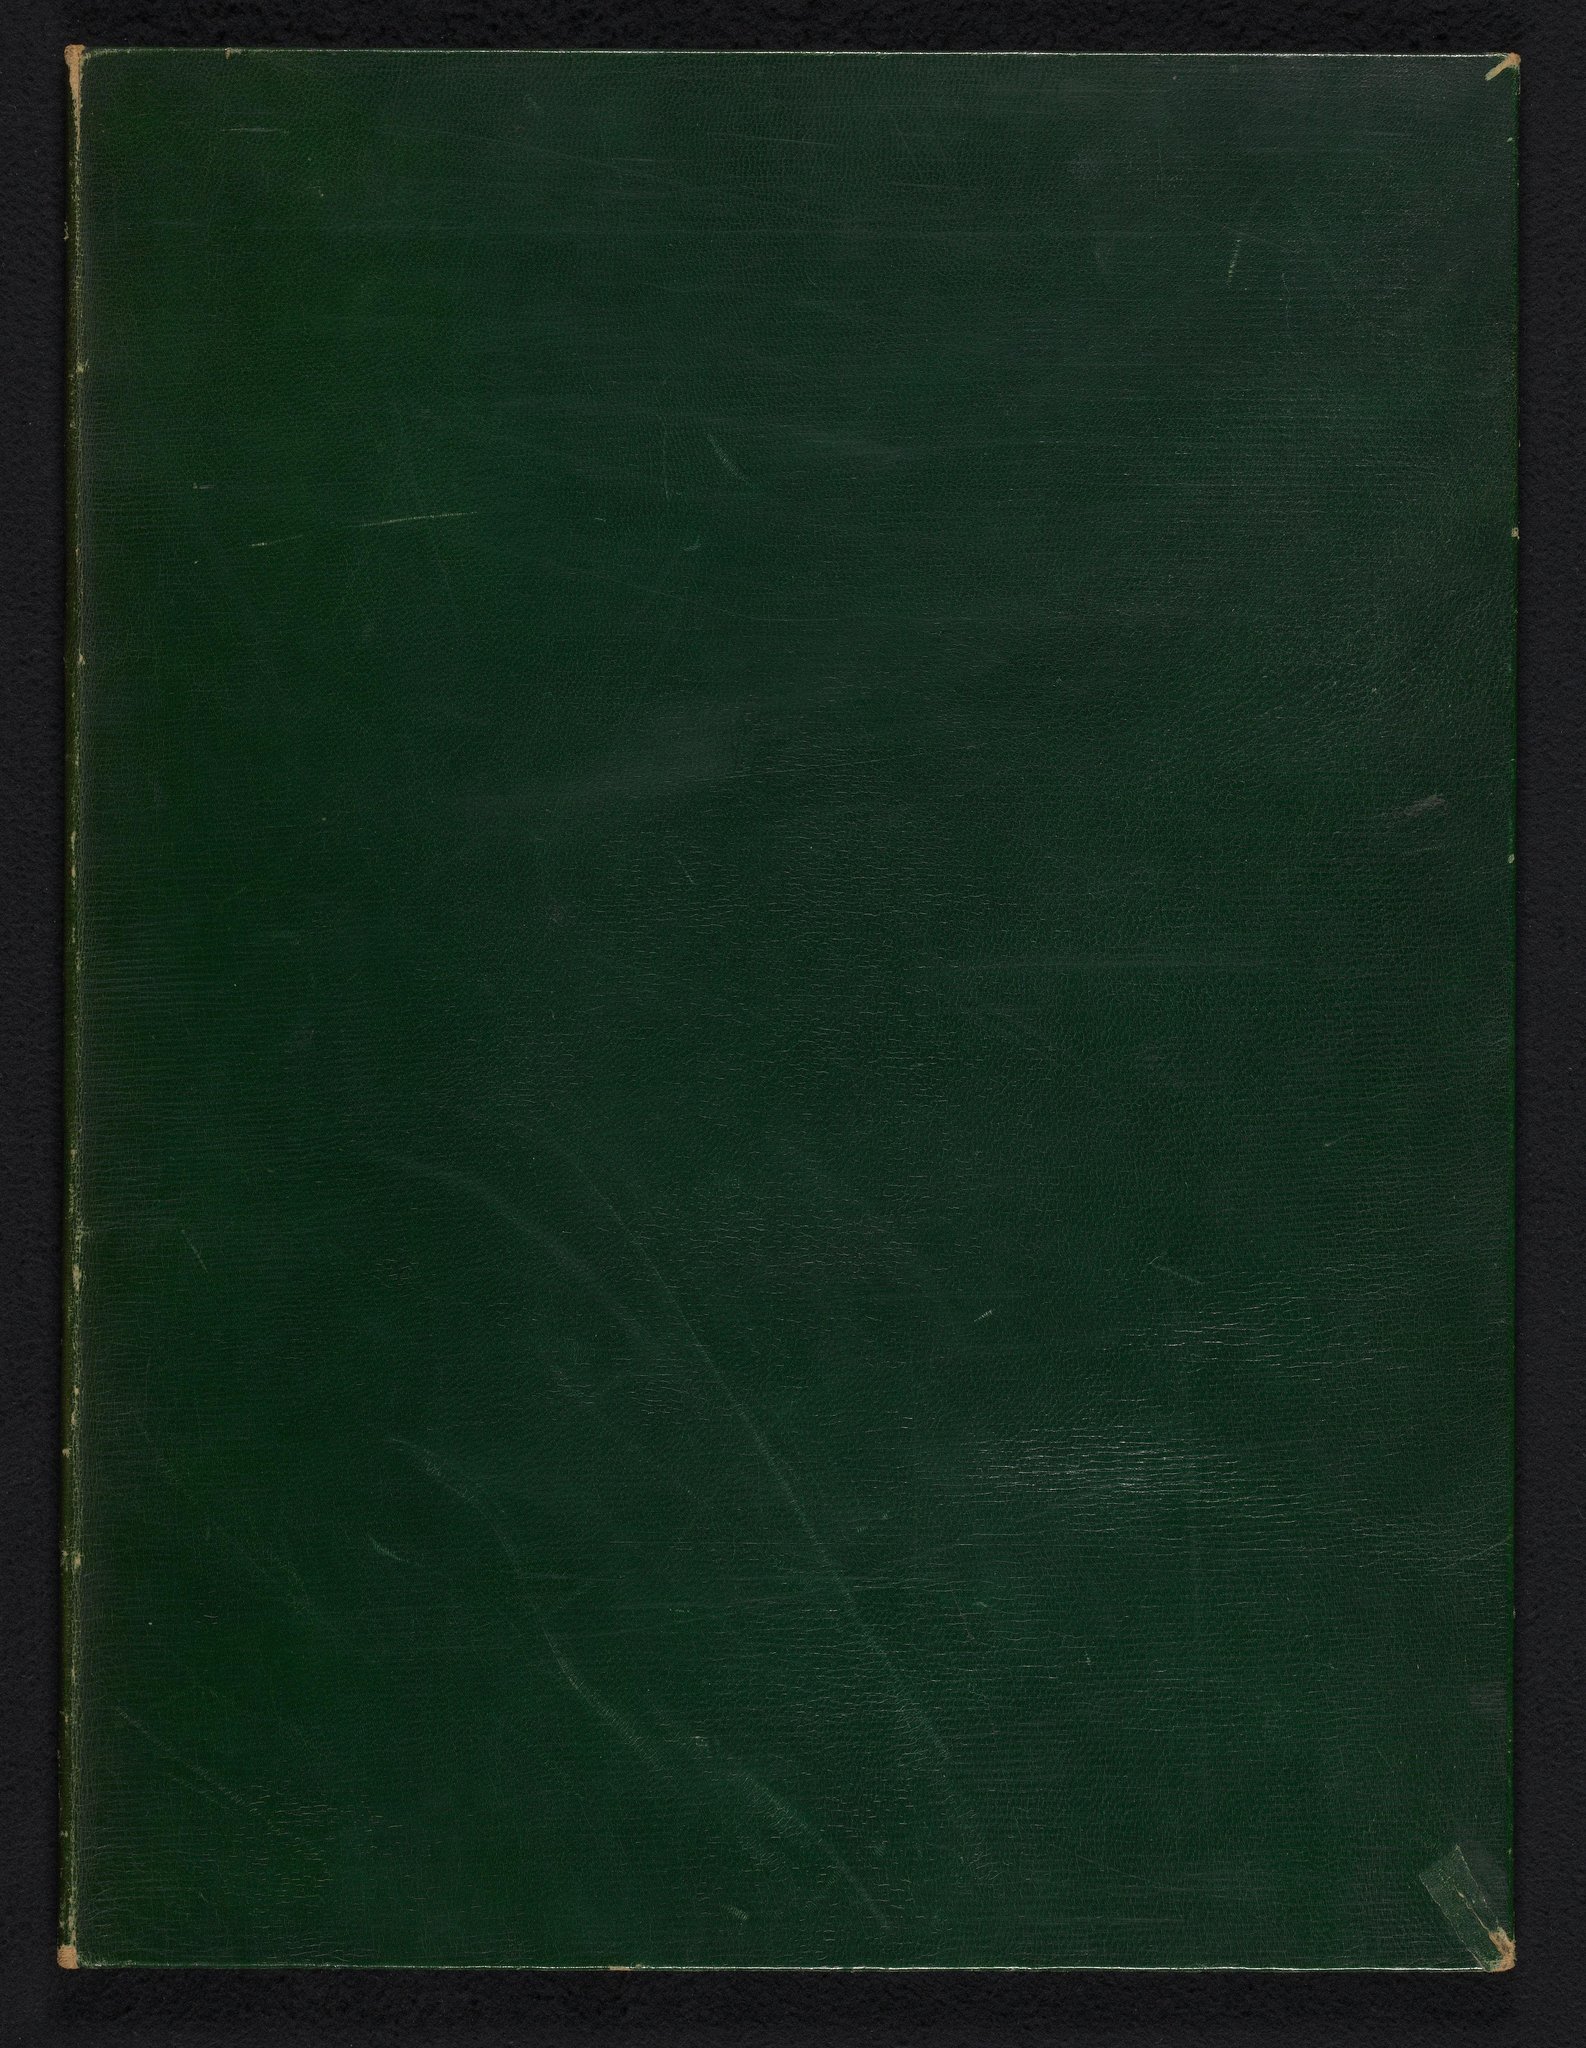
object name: prentrecueil, prentenalbum, prentalbum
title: Masson - Desseins d'orfevrerie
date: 1700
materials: cardboard, paper, vegetable tanned sheepskin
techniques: bookbinding, printing, engraving, etching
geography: paris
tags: jeweller, goldsmith, silversmith, ornamenting, decorating ~ applied arts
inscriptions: collector's mark: Lugt 2228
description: Album met zes prenten op zes bladen. De prenten komen uit de serie 'Nouveaux desseins pour graver sur l'orfevrerie', met elk meerdere ontwerpen voor edelsmeedkunst, waaronder schalen, bekers, borden, suikerpotten, theepotten en decoratieve elementen.